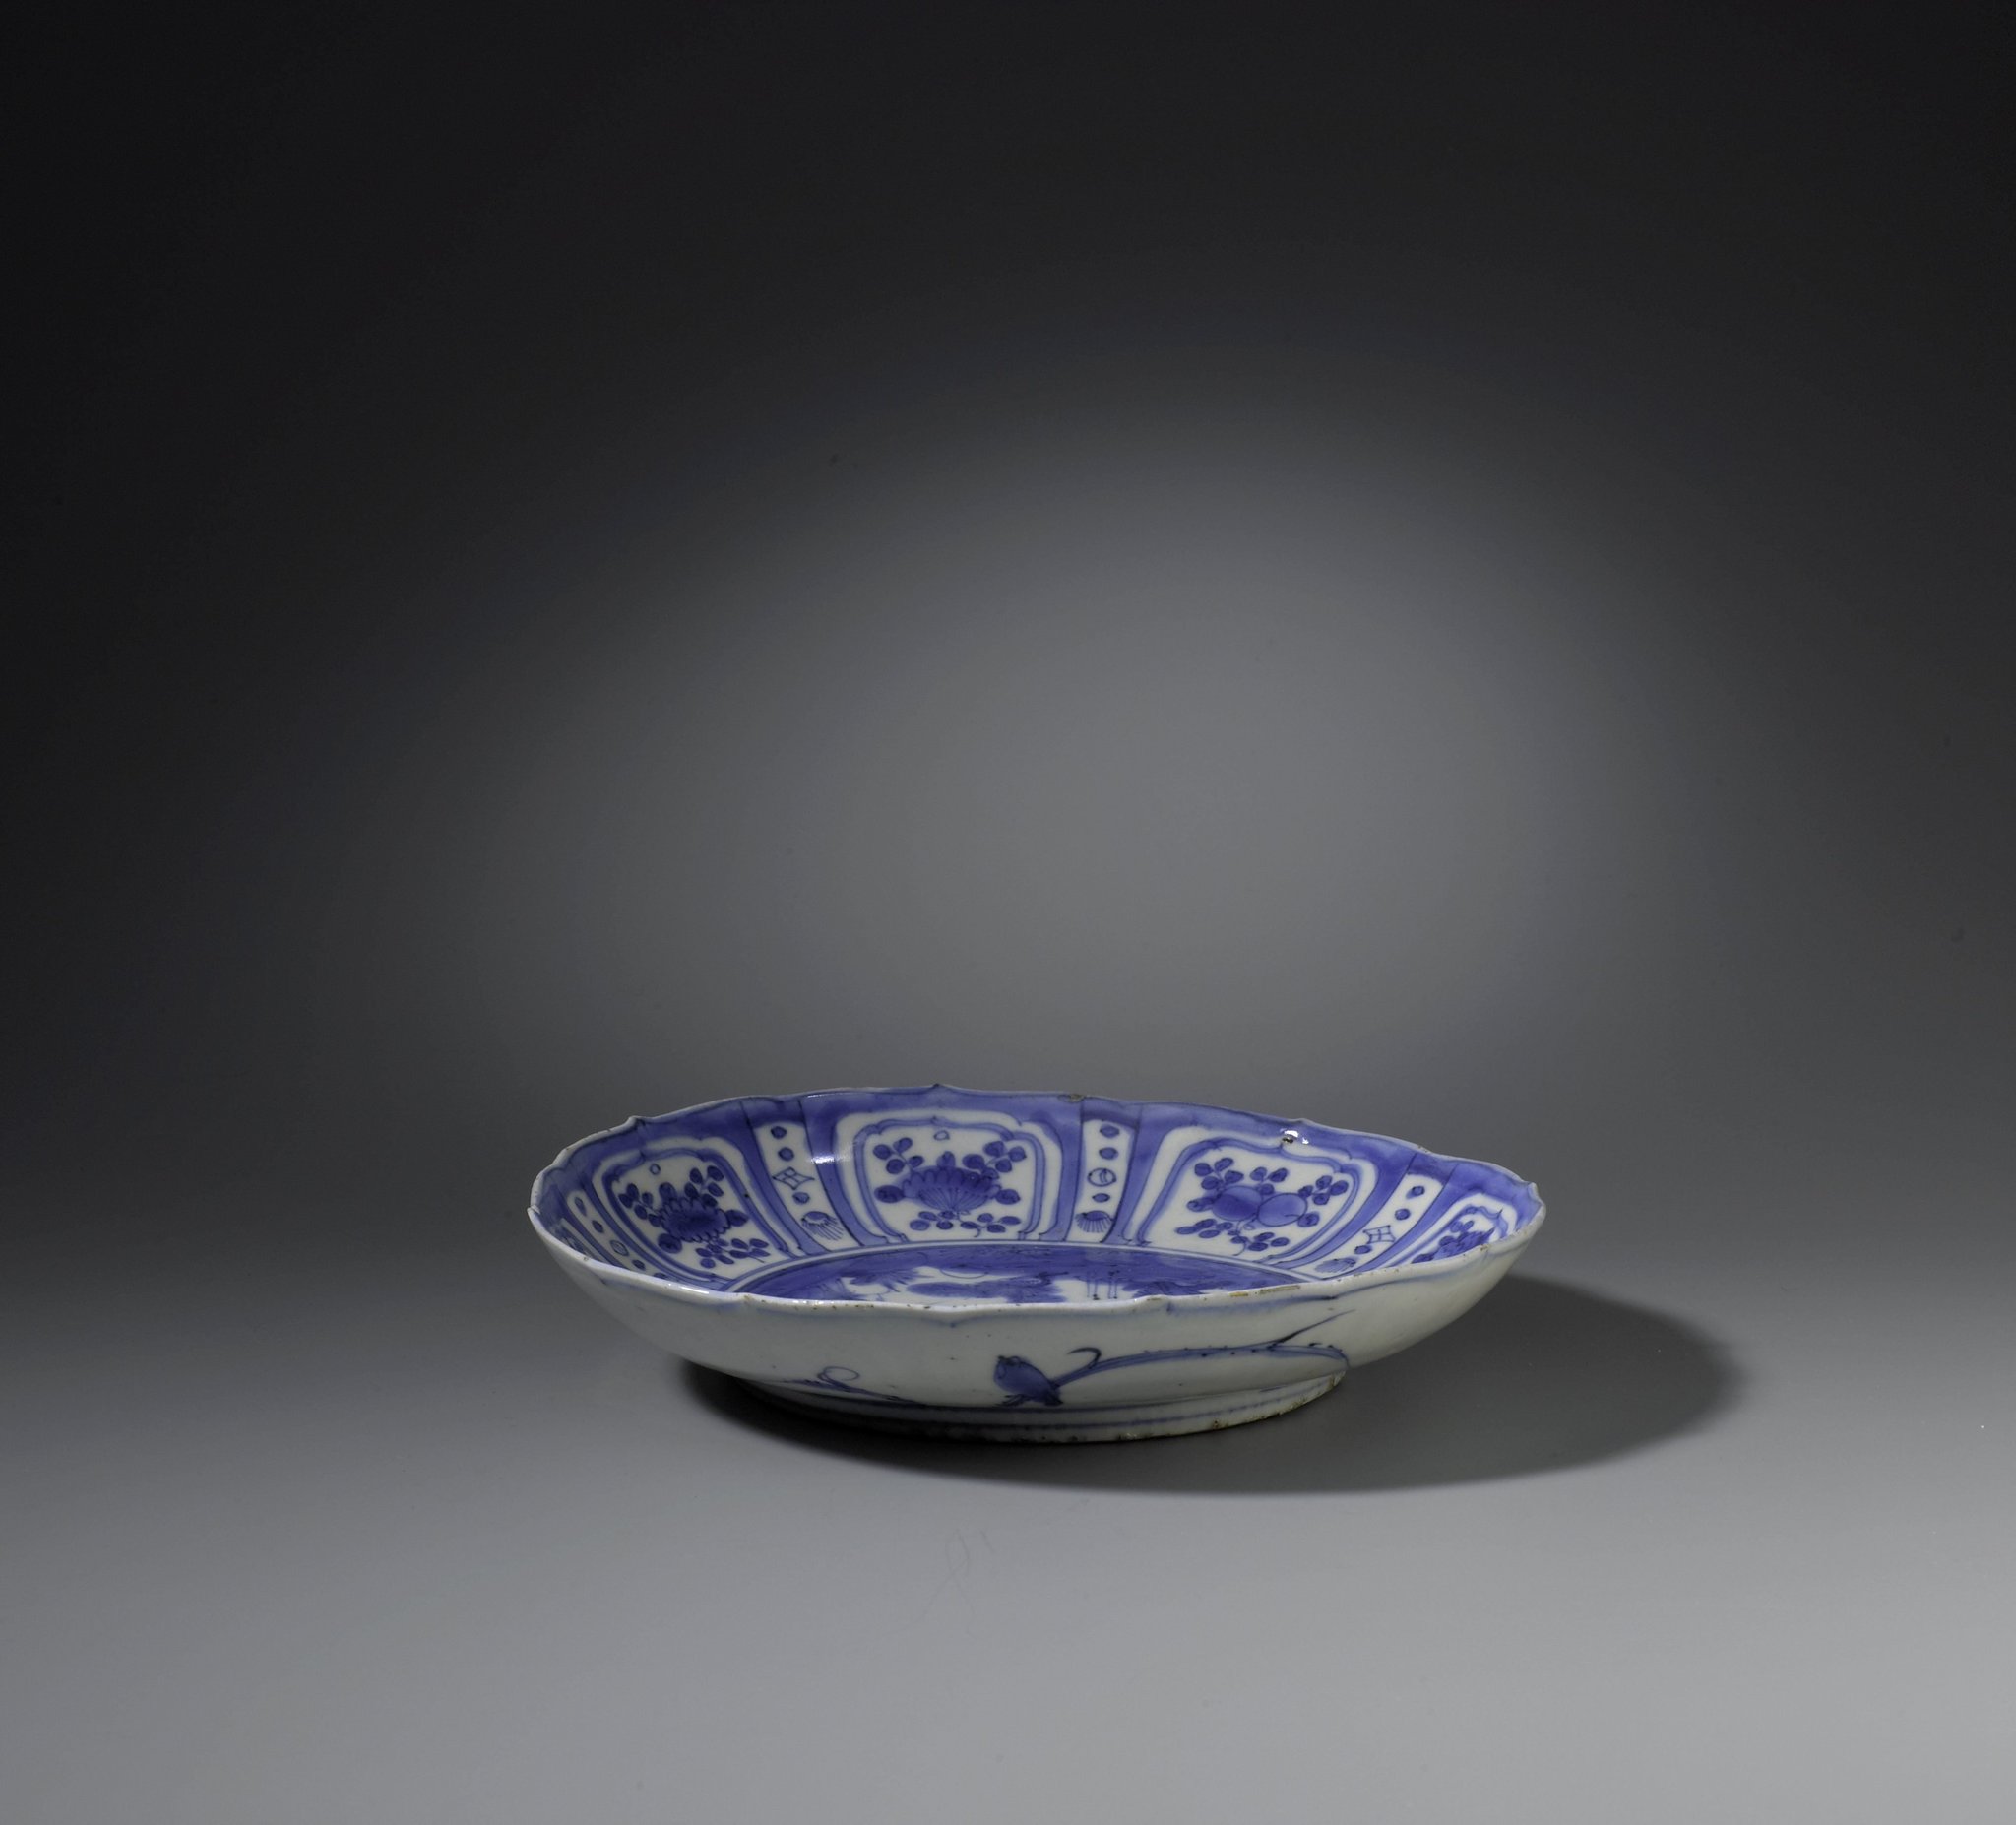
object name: dish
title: Saucer-dish with four deer in a landscape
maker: Anonymous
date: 1600-1624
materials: cobalt, glaze, paint, porcelain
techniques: firing, turning, vitrification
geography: china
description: Schaal met een accoladevormige rand, gedecoreerd in onderglazuur blauw. In het plat een voorstelling van vier herten in een landschap, omgeven door een band met velden op de rand; in de velden bloemtakken en stipwerk. Op de achterzijde twee takken met een vogel.